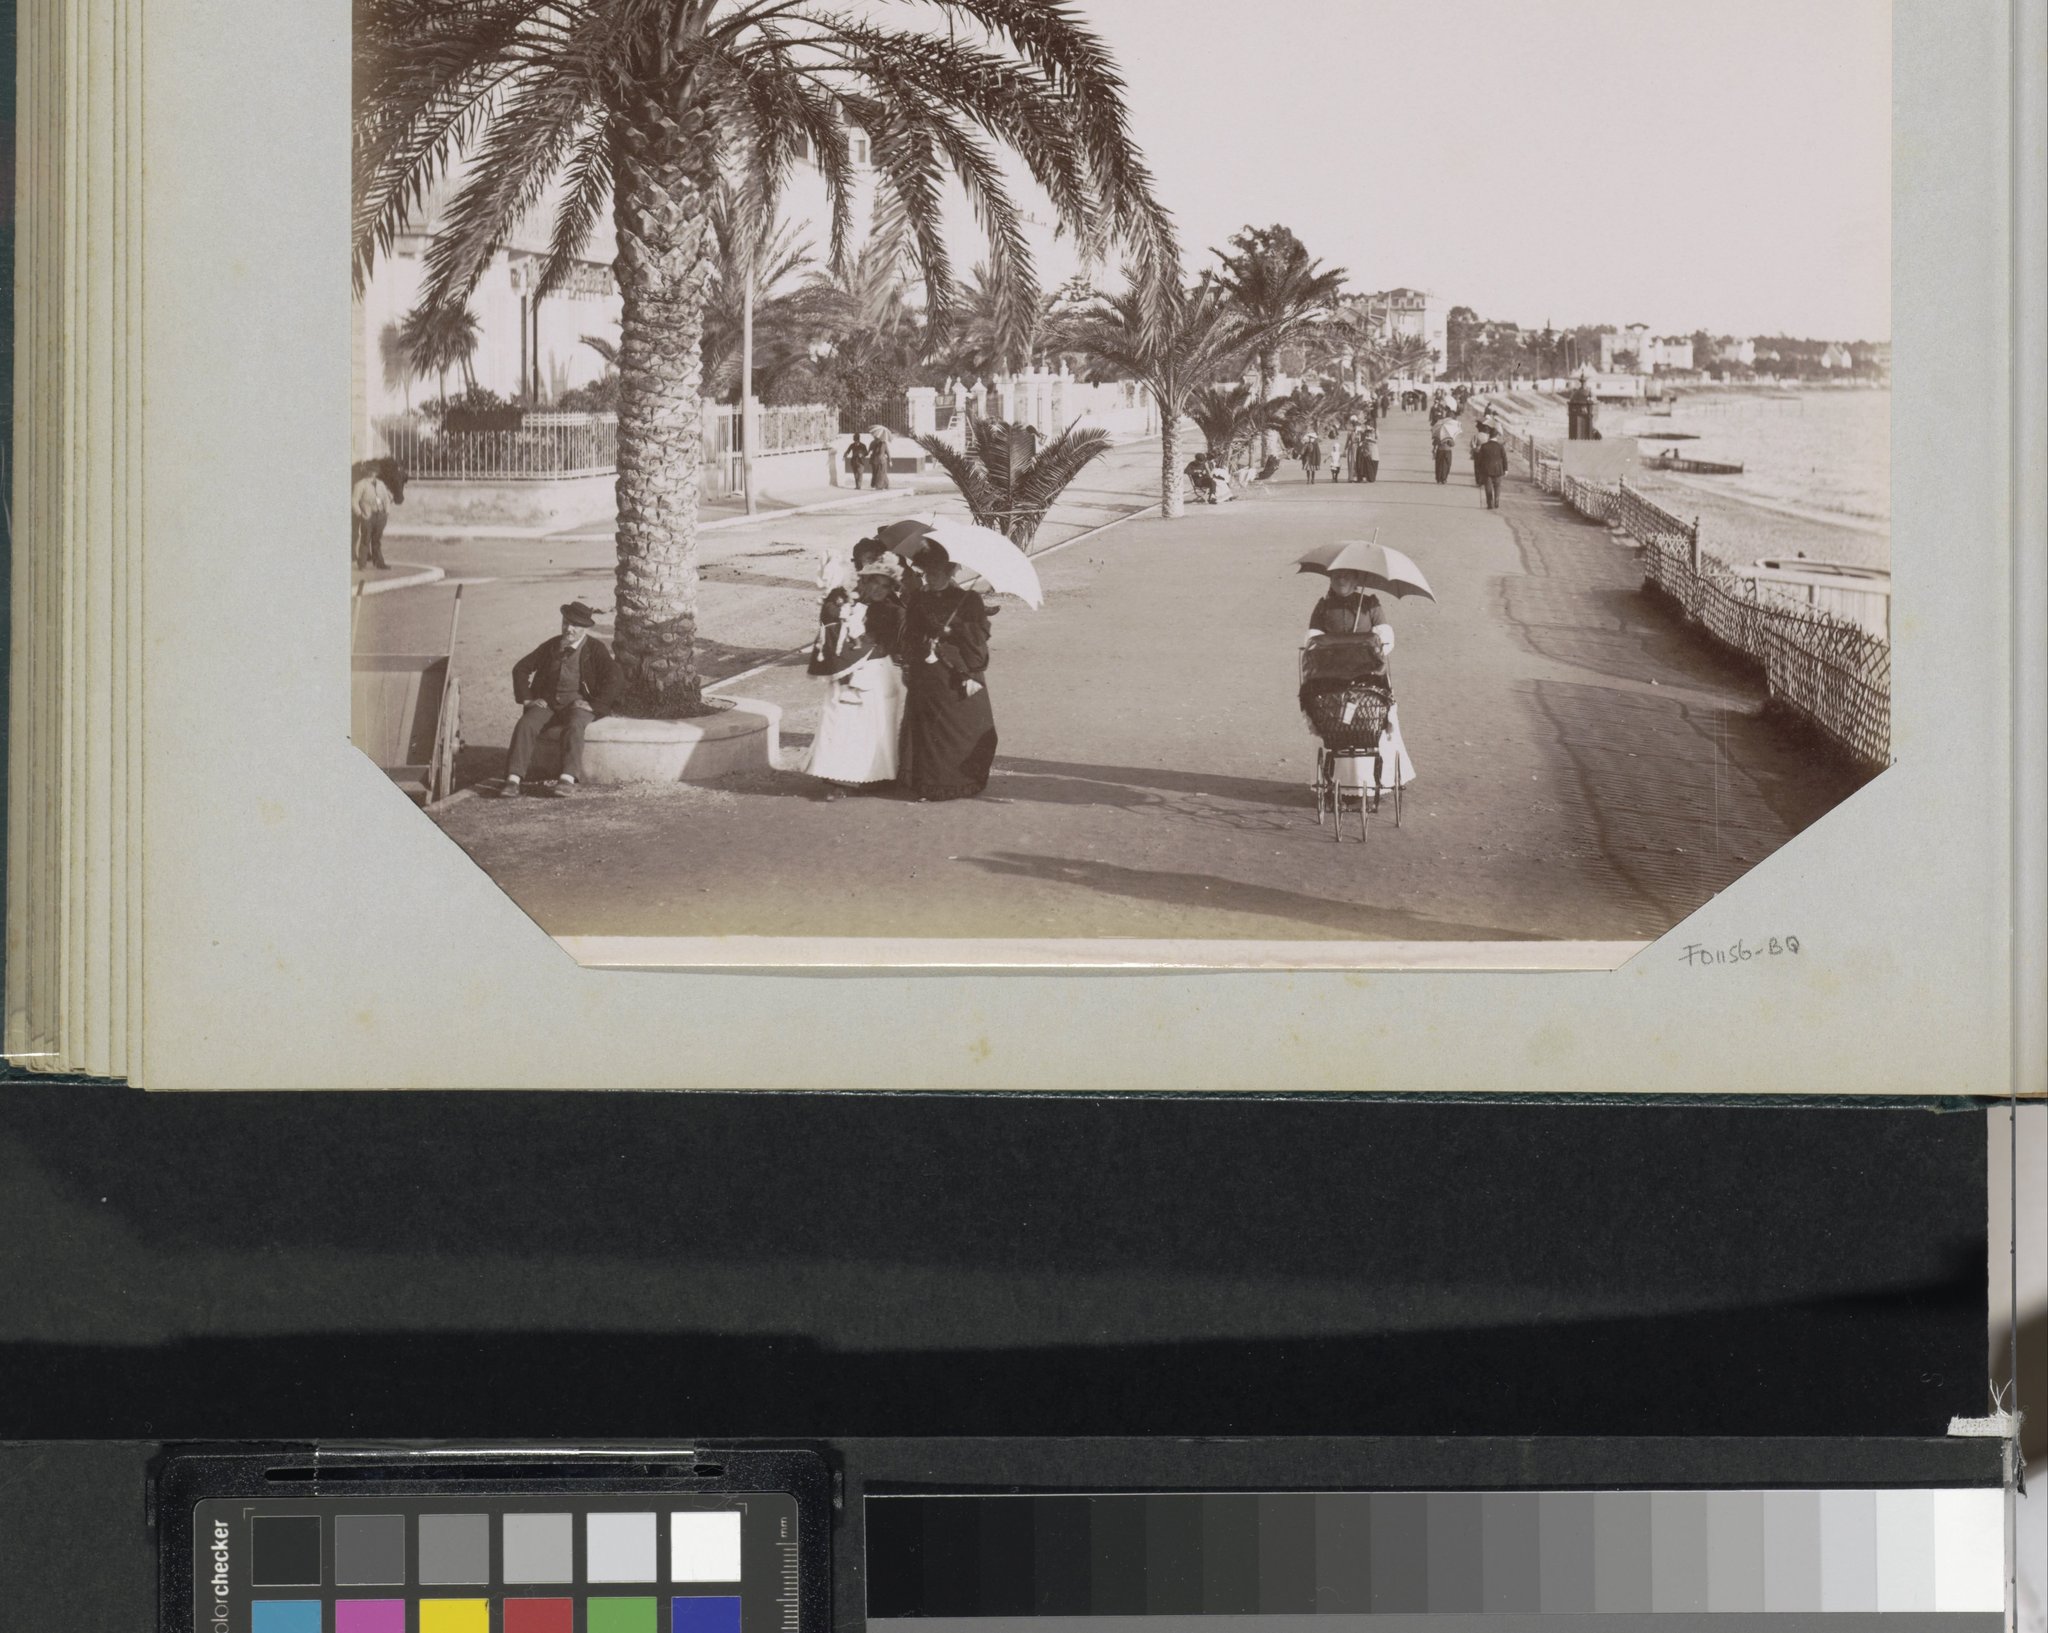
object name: album leaf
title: Boulevard met wandelaars, vermoedelijk te Hyères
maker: Anonymous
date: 1896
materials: photographic support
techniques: albumen print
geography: provence-alpes-côte d'azur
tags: avenue, boulevard, promenade, esplanade (+ city(-scape) with figures, staffage)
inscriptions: date